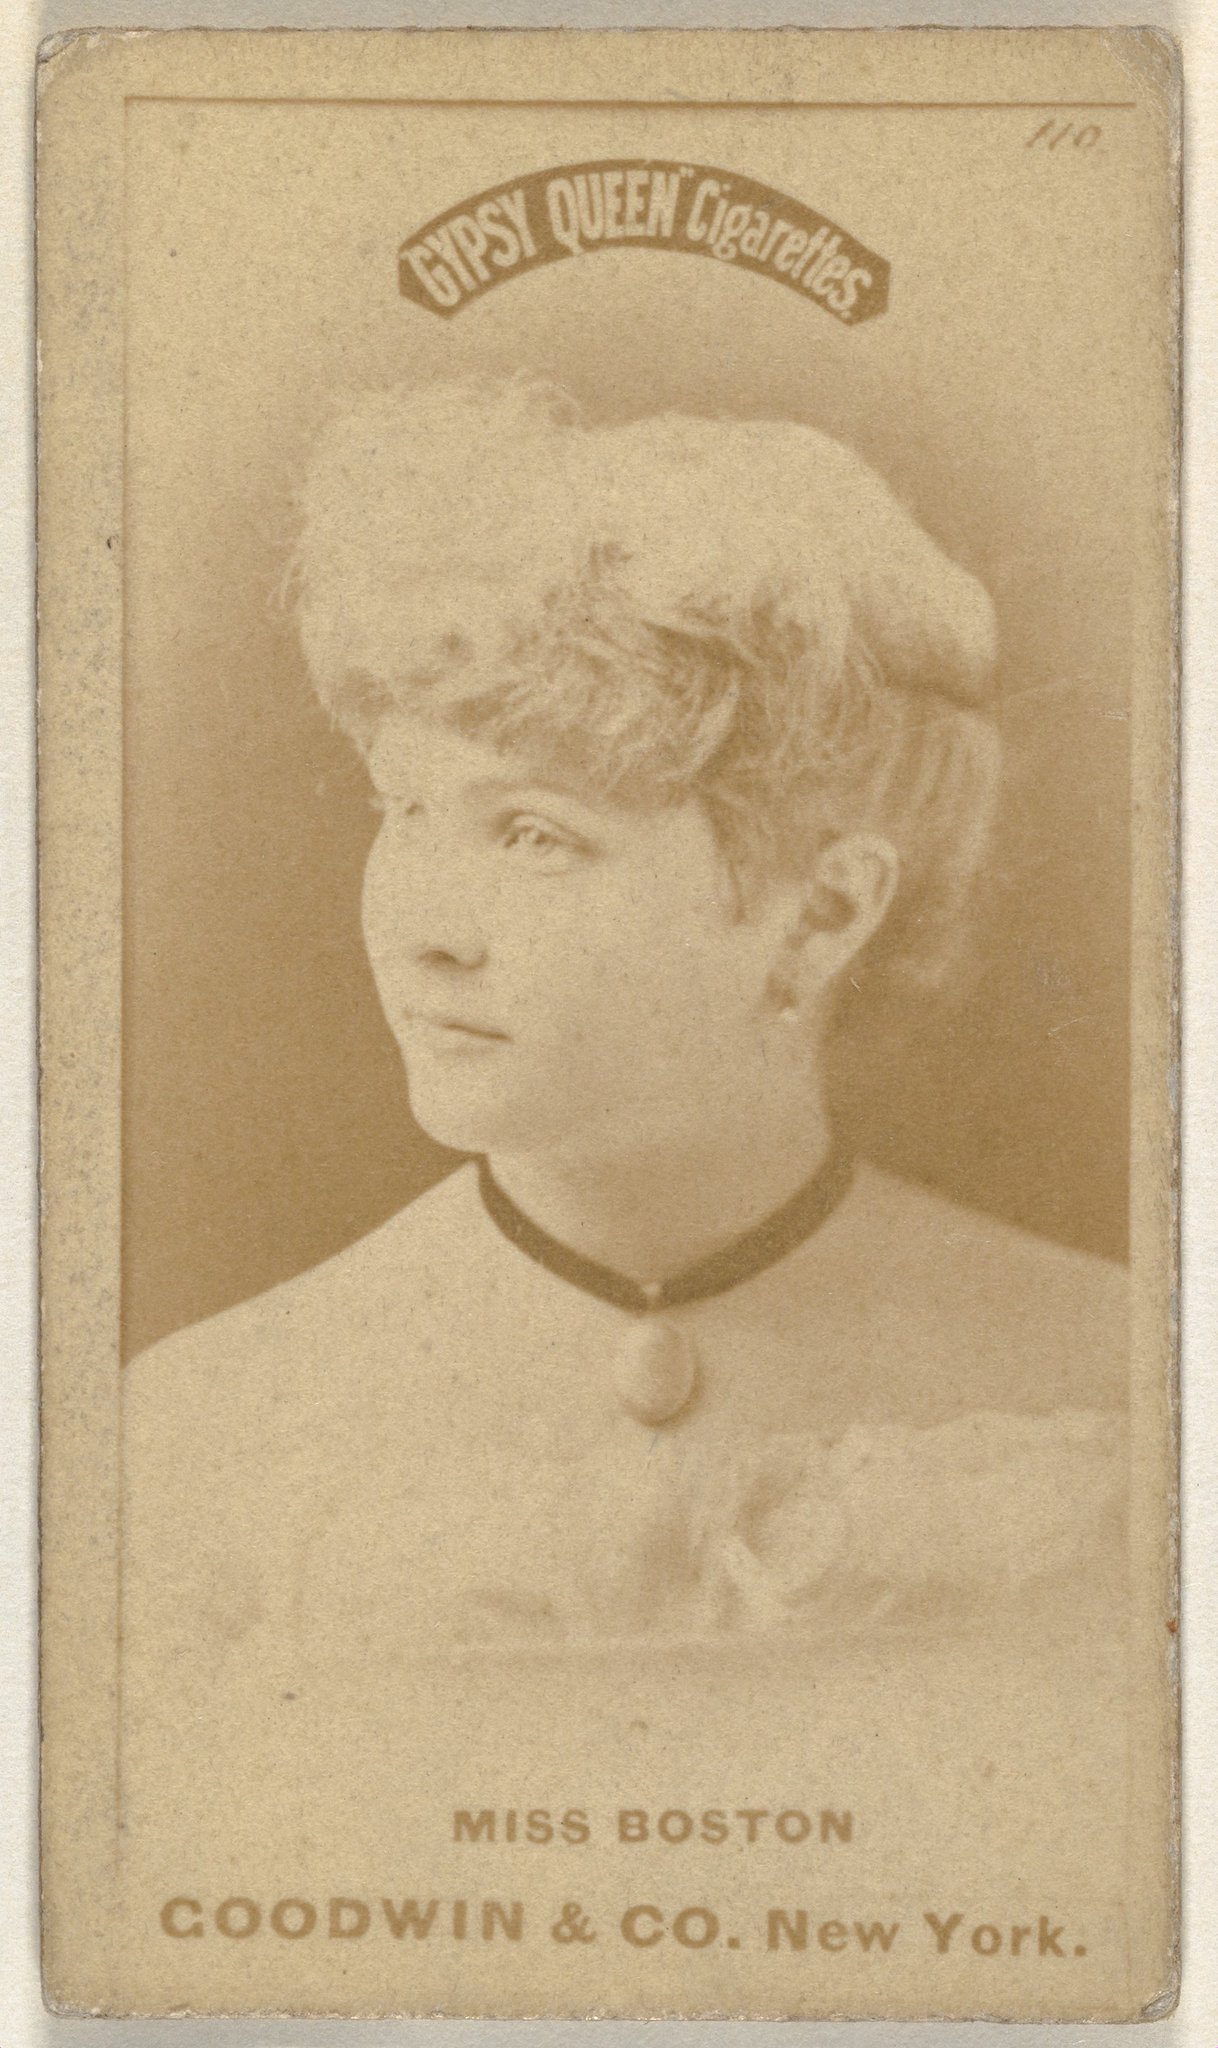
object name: photograph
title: Miss Boston, from the Actors and Actresses series (N171) for Gypsy Queen Cigarettes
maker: goodwin & company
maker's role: publisher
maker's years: 1850-1950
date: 1886-1890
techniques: albumen silver print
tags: portraits,women,actresses